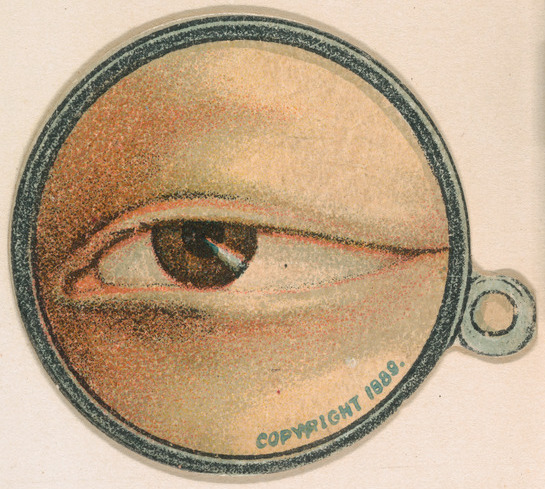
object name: print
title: Monocle and Eye (brown), from Jocular Ocular series (N221) issued by Kinney Bros.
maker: kinney brothers tobacco company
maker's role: publisher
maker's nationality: american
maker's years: 1869-2011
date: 1889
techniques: color lithograph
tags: eyes